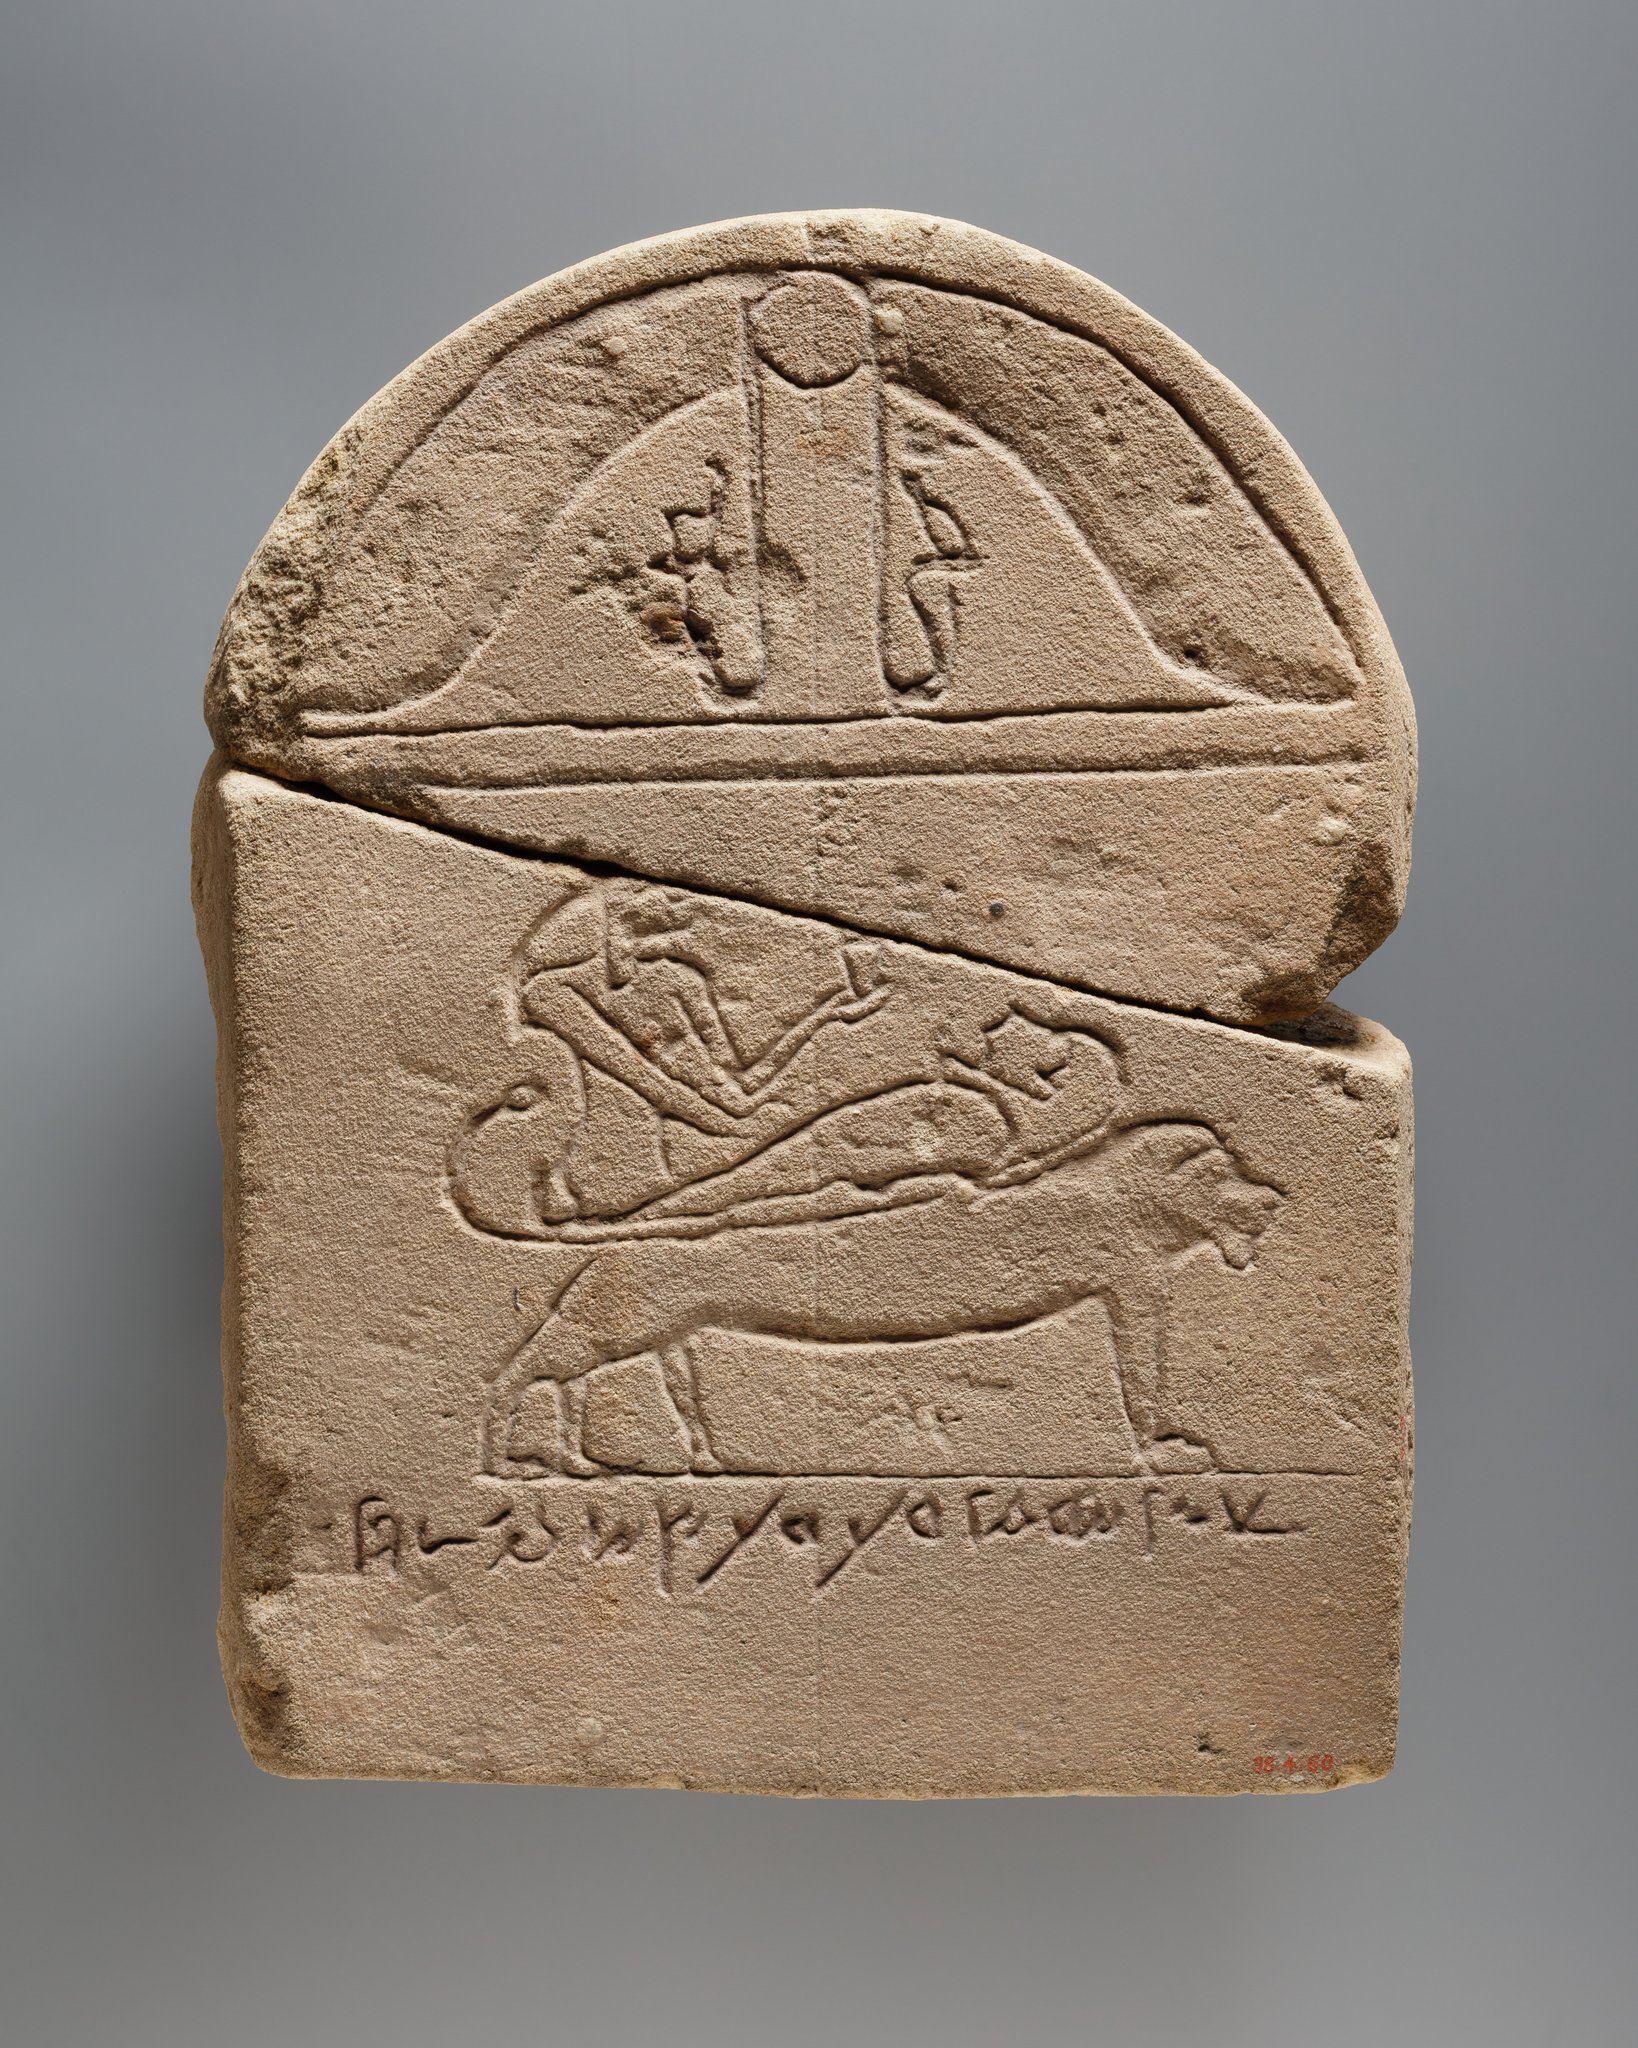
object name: stela, anubis, mummy on bed, for pachom alal, son of peteharsomtous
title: Stela depicting Anubis and a mummy on a bed for for Pachom-alal, son of Peteharsomtous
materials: stone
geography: egypt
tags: animals,anubis,mummies